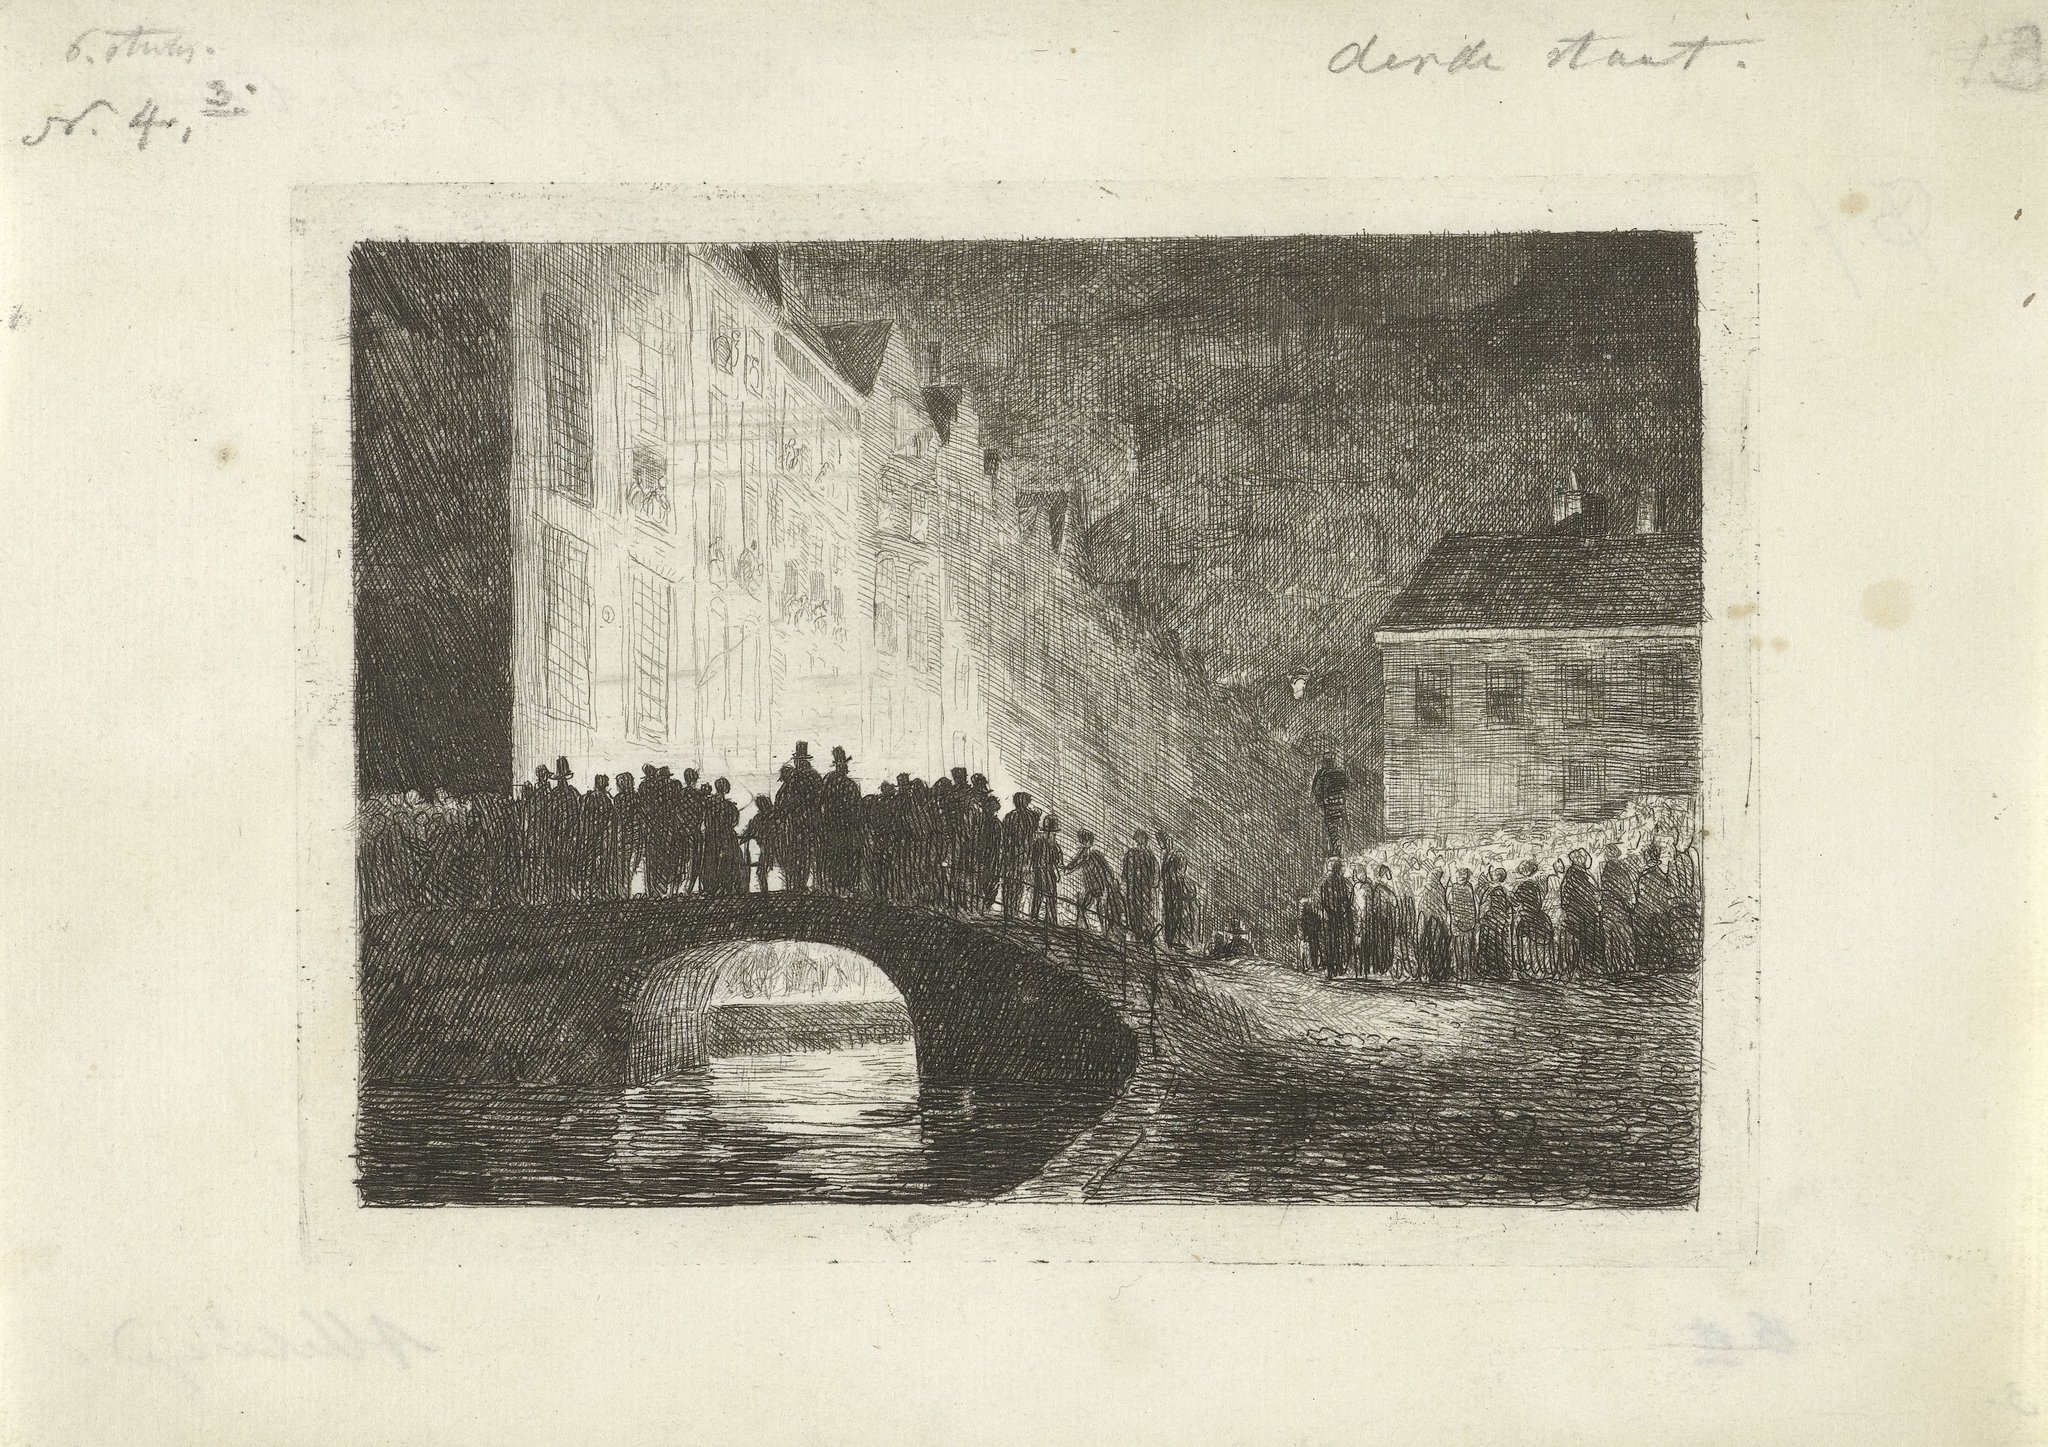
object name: print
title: Serenade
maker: cornelis van der griendt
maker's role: draughtsman, painter, print maker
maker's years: 1827-1918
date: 1852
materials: paper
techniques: etching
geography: netherlands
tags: city-view in general; 'veduta' (+ city(-scape) with figures, staffage)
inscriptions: collector's mark: Lugt 2228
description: Nachtelijk stadsgezicht met een zanger en toeschouwers.